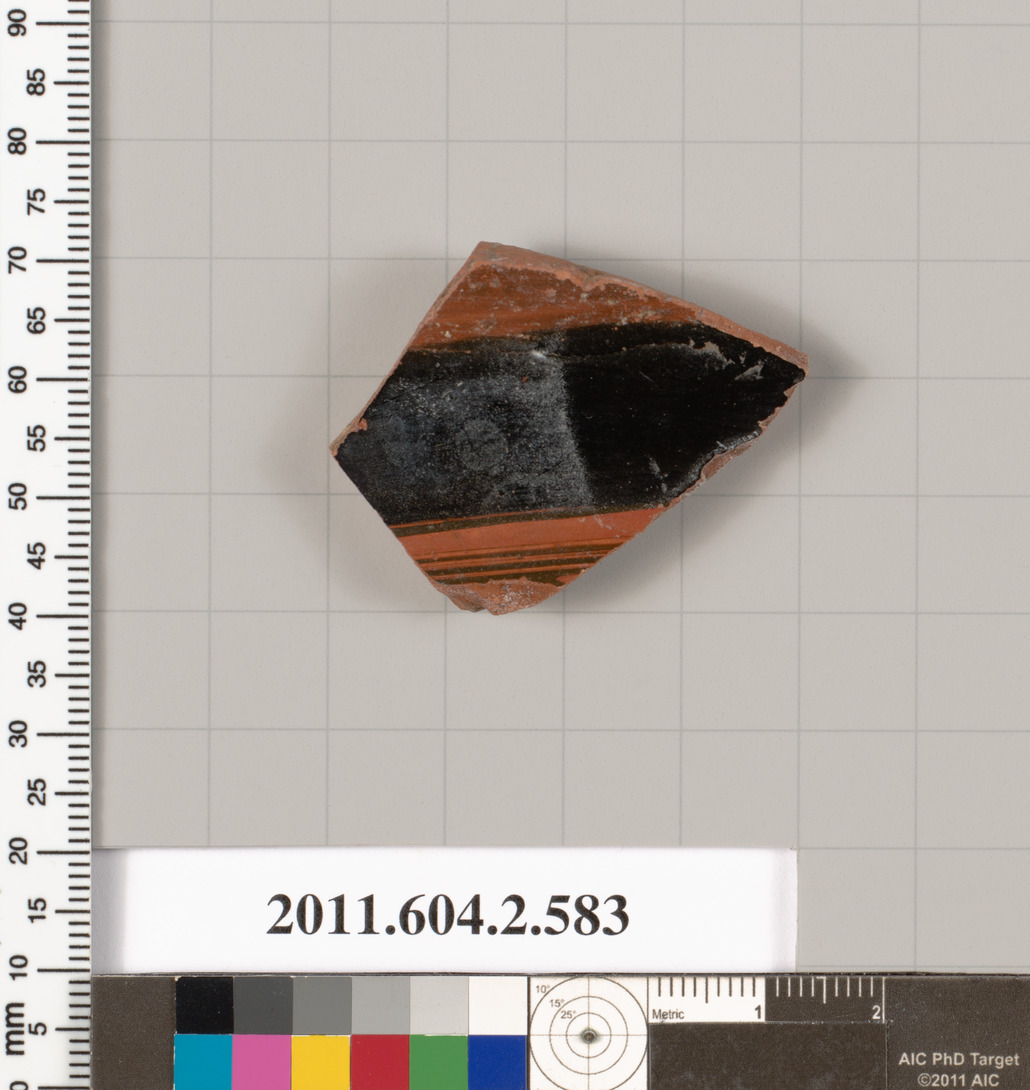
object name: column krater fragment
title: Terracotta fragment of a column-krater (bowl for mixing wine and water)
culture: greek, attic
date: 460-440 BCE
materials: terracotta